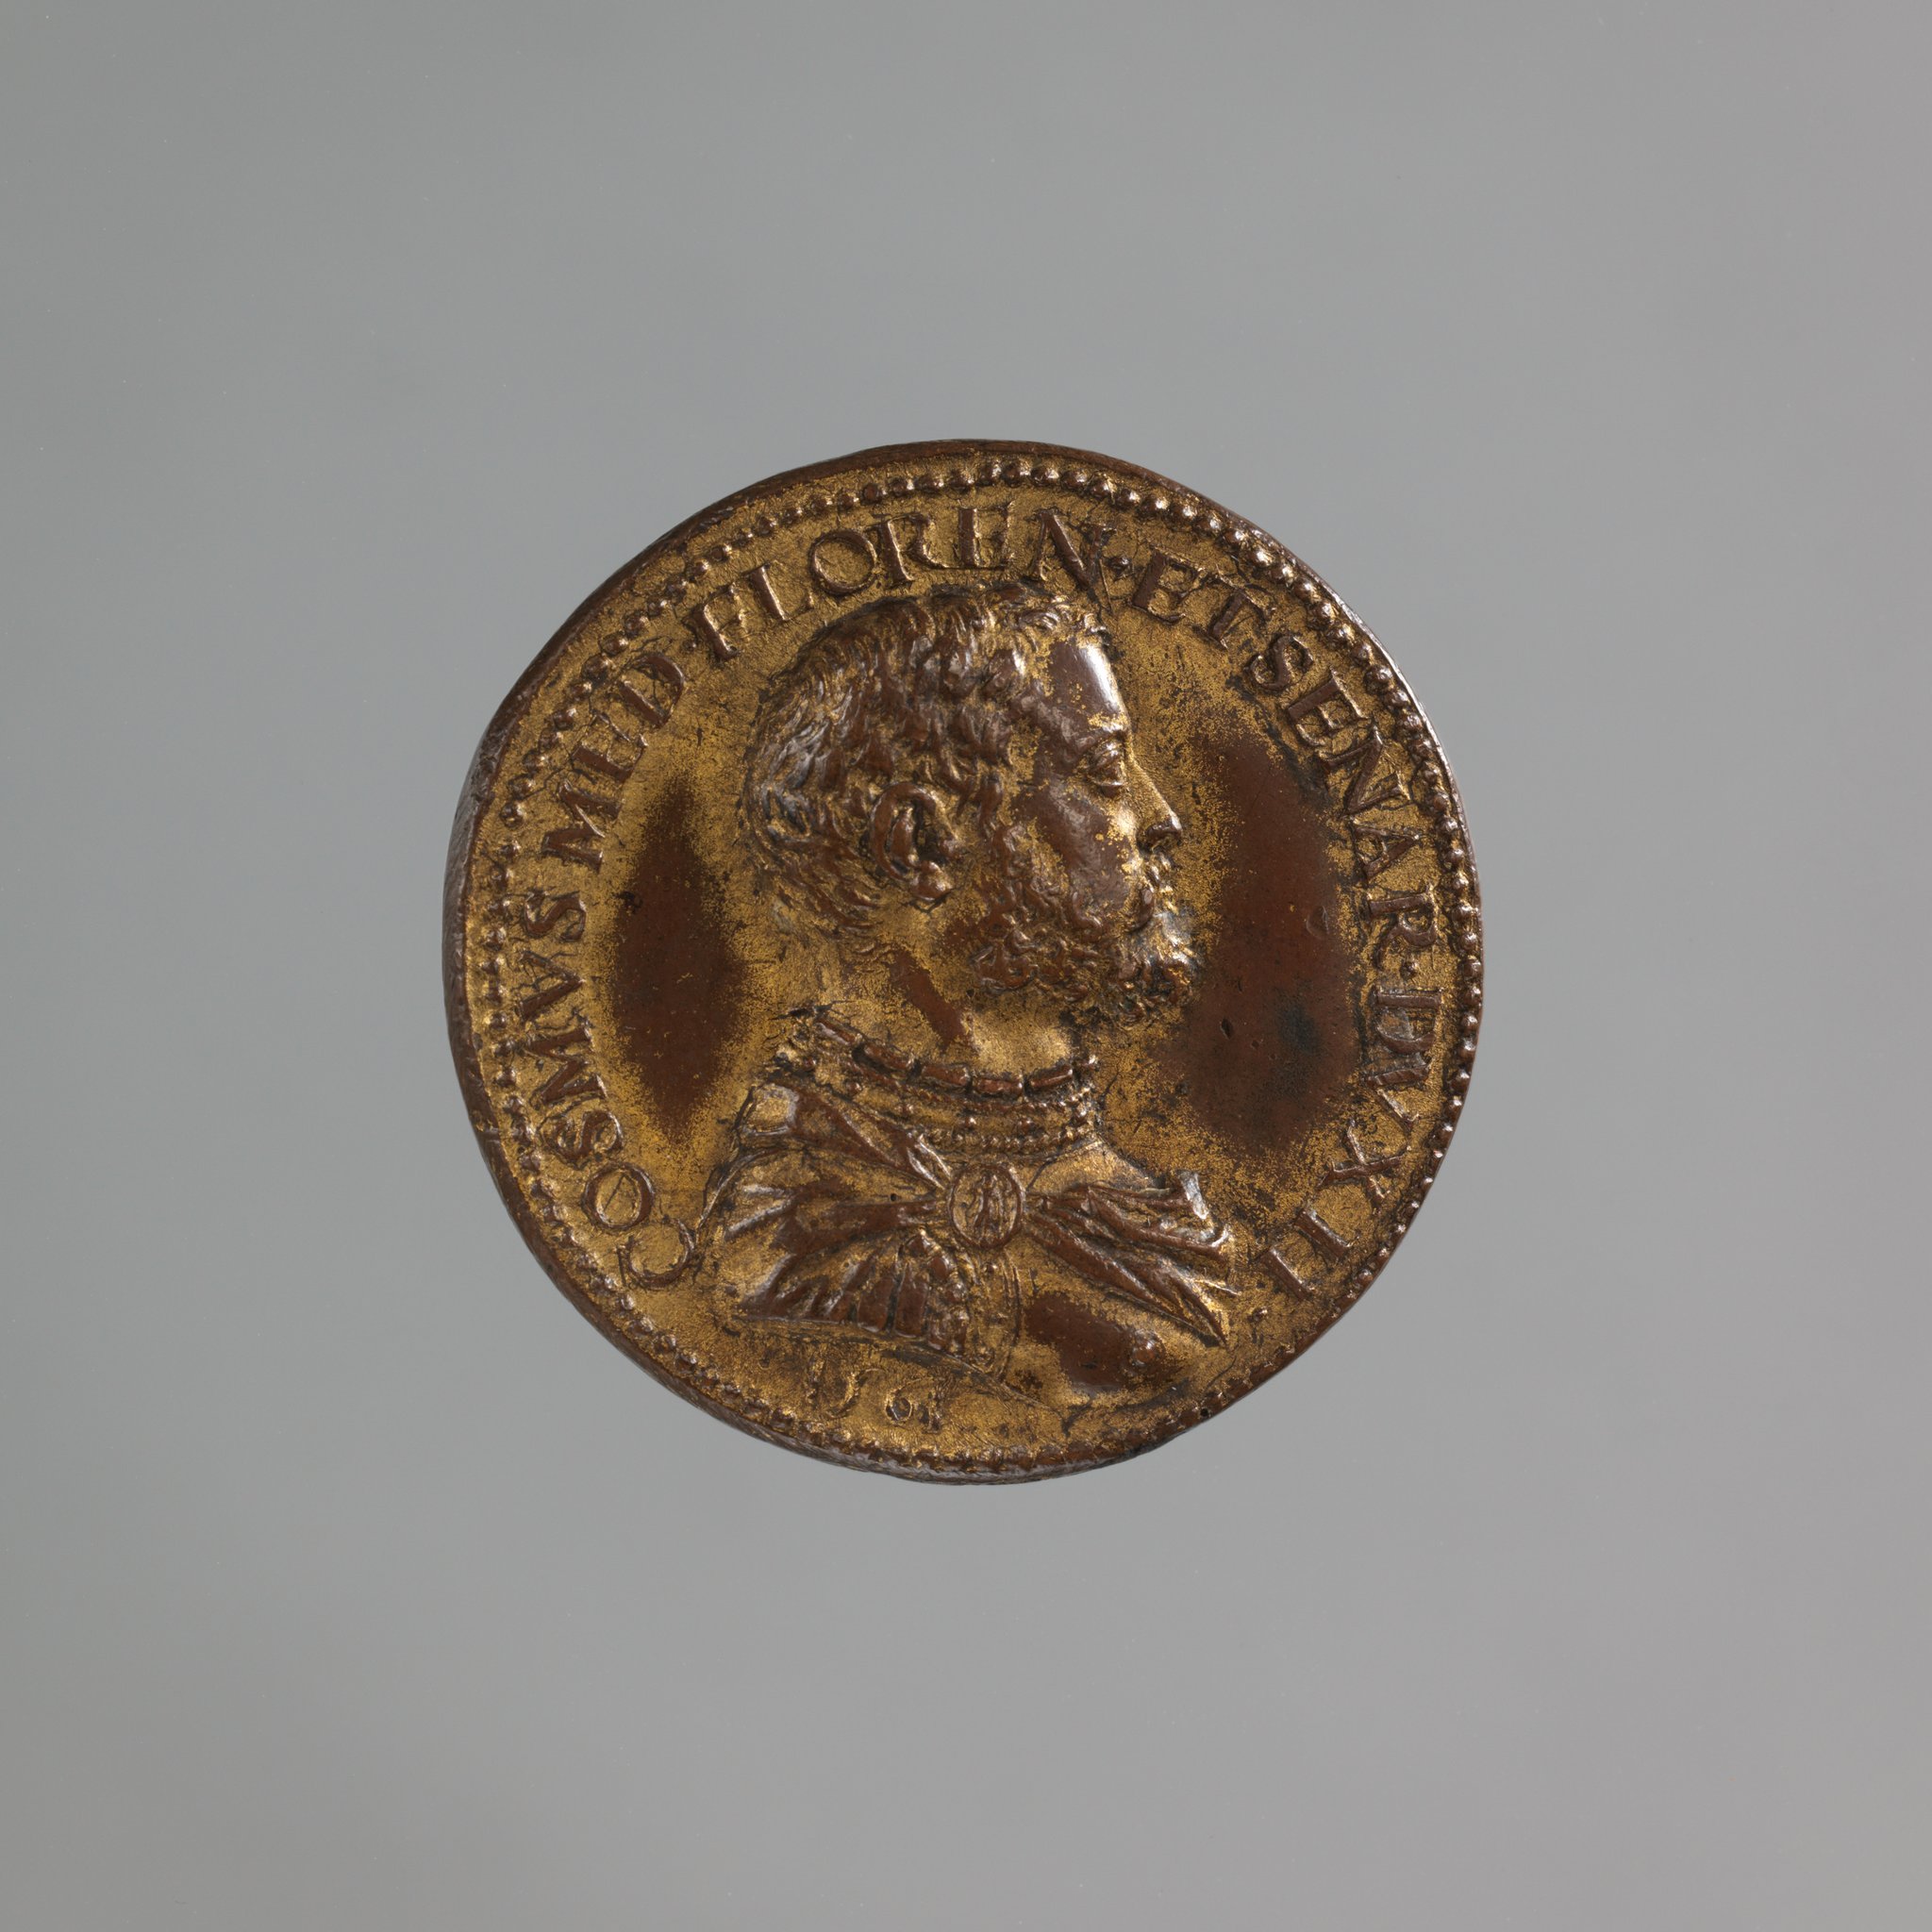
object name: medal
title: Cosimo I de'Medici (1519–1574), Duke of Florence, 1537; Grand Duke of Tuscany, 1569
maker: domenico poggini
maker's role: artist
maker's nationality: italian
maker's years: 1520-1590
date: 1561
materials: gilt bronze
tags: men,profiles